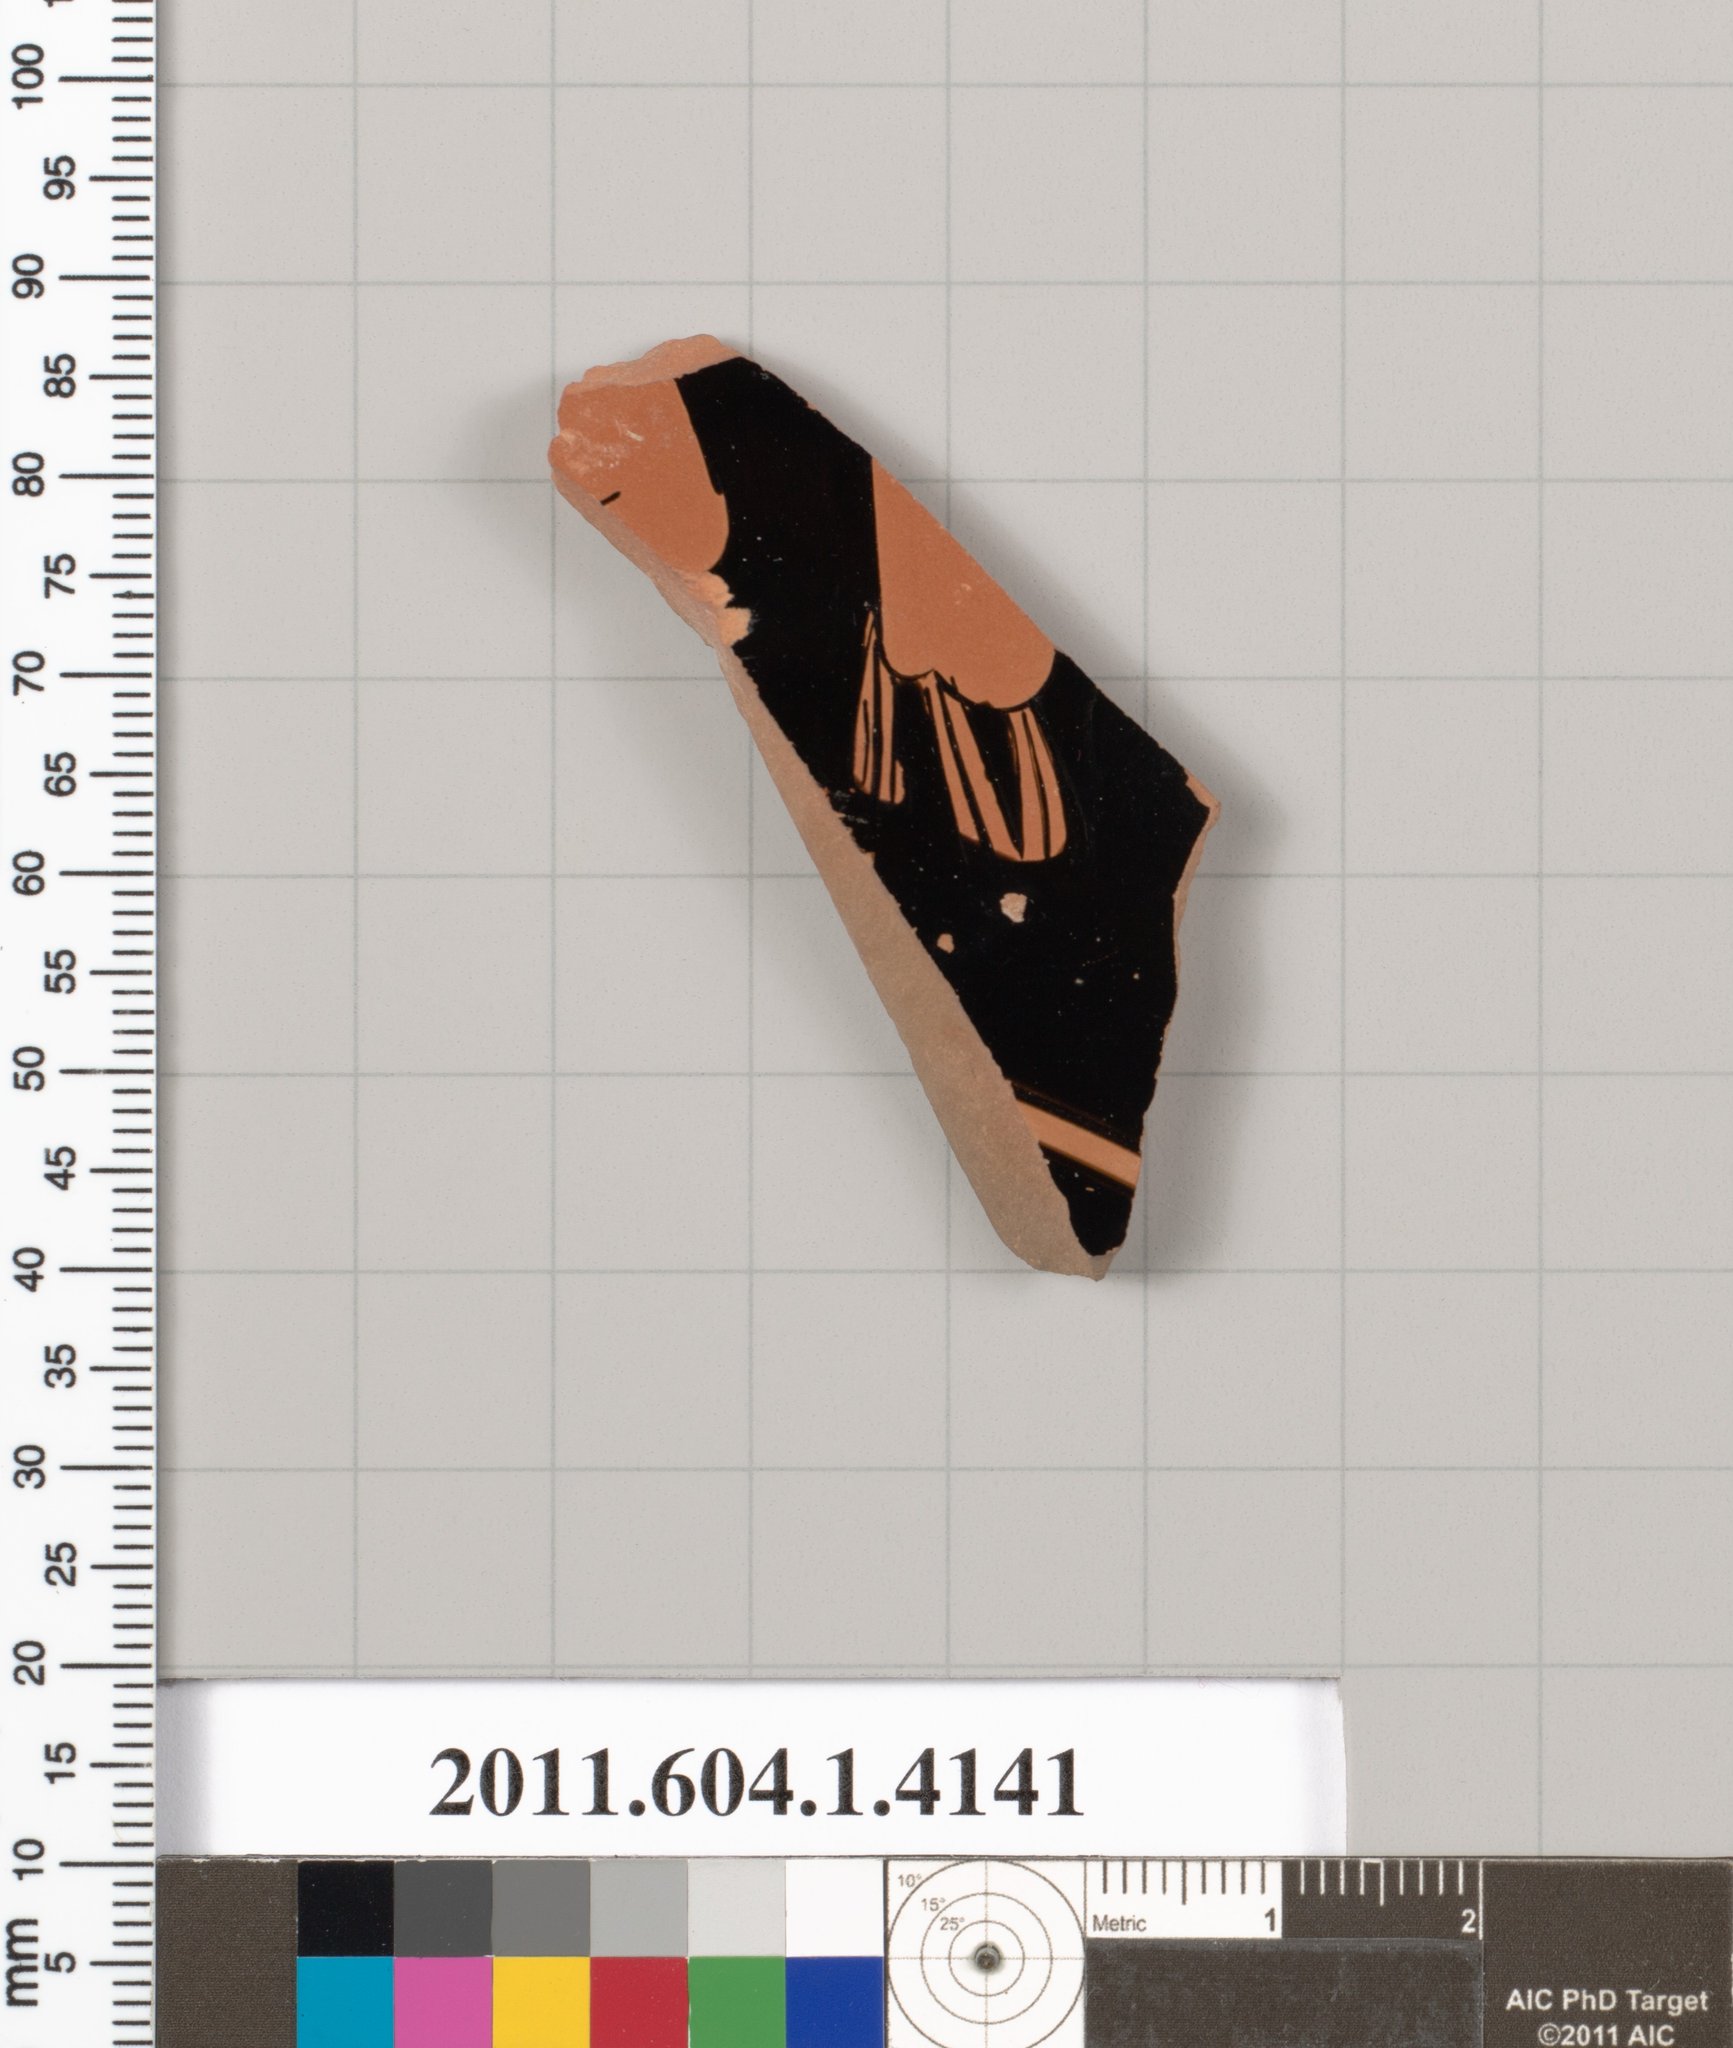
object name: kylix fragment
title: Terracotta fragment of a kylix (drinking cup)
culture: greek, attic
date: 490-470 BCE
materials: terracotta